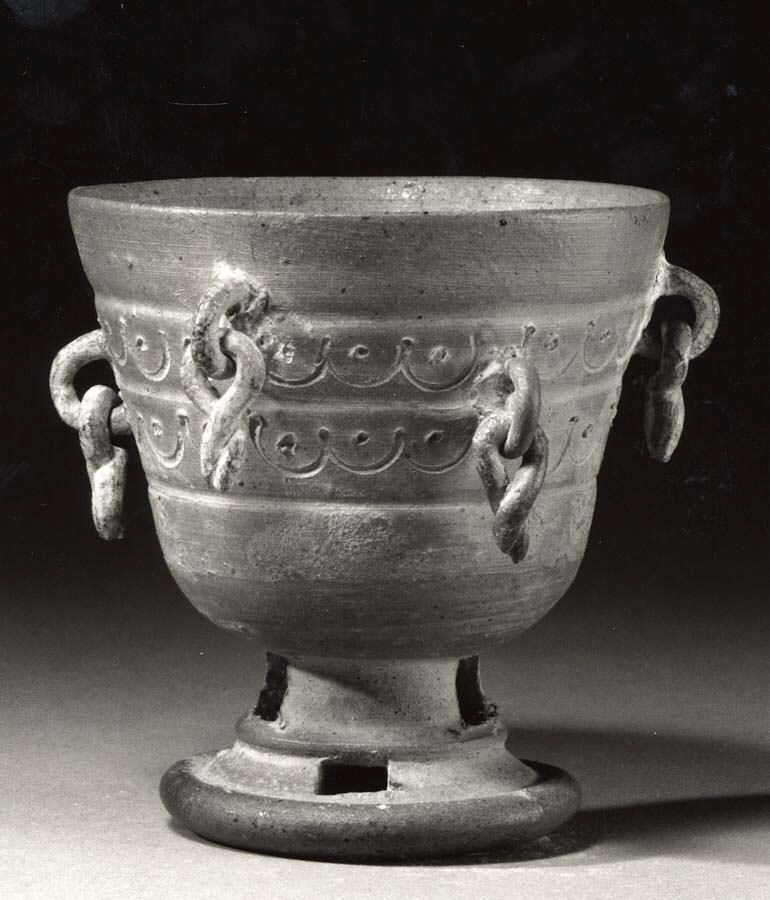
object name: pedestal cup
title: Pedestal cup with pendants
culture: korean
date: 401-600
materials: stoneware